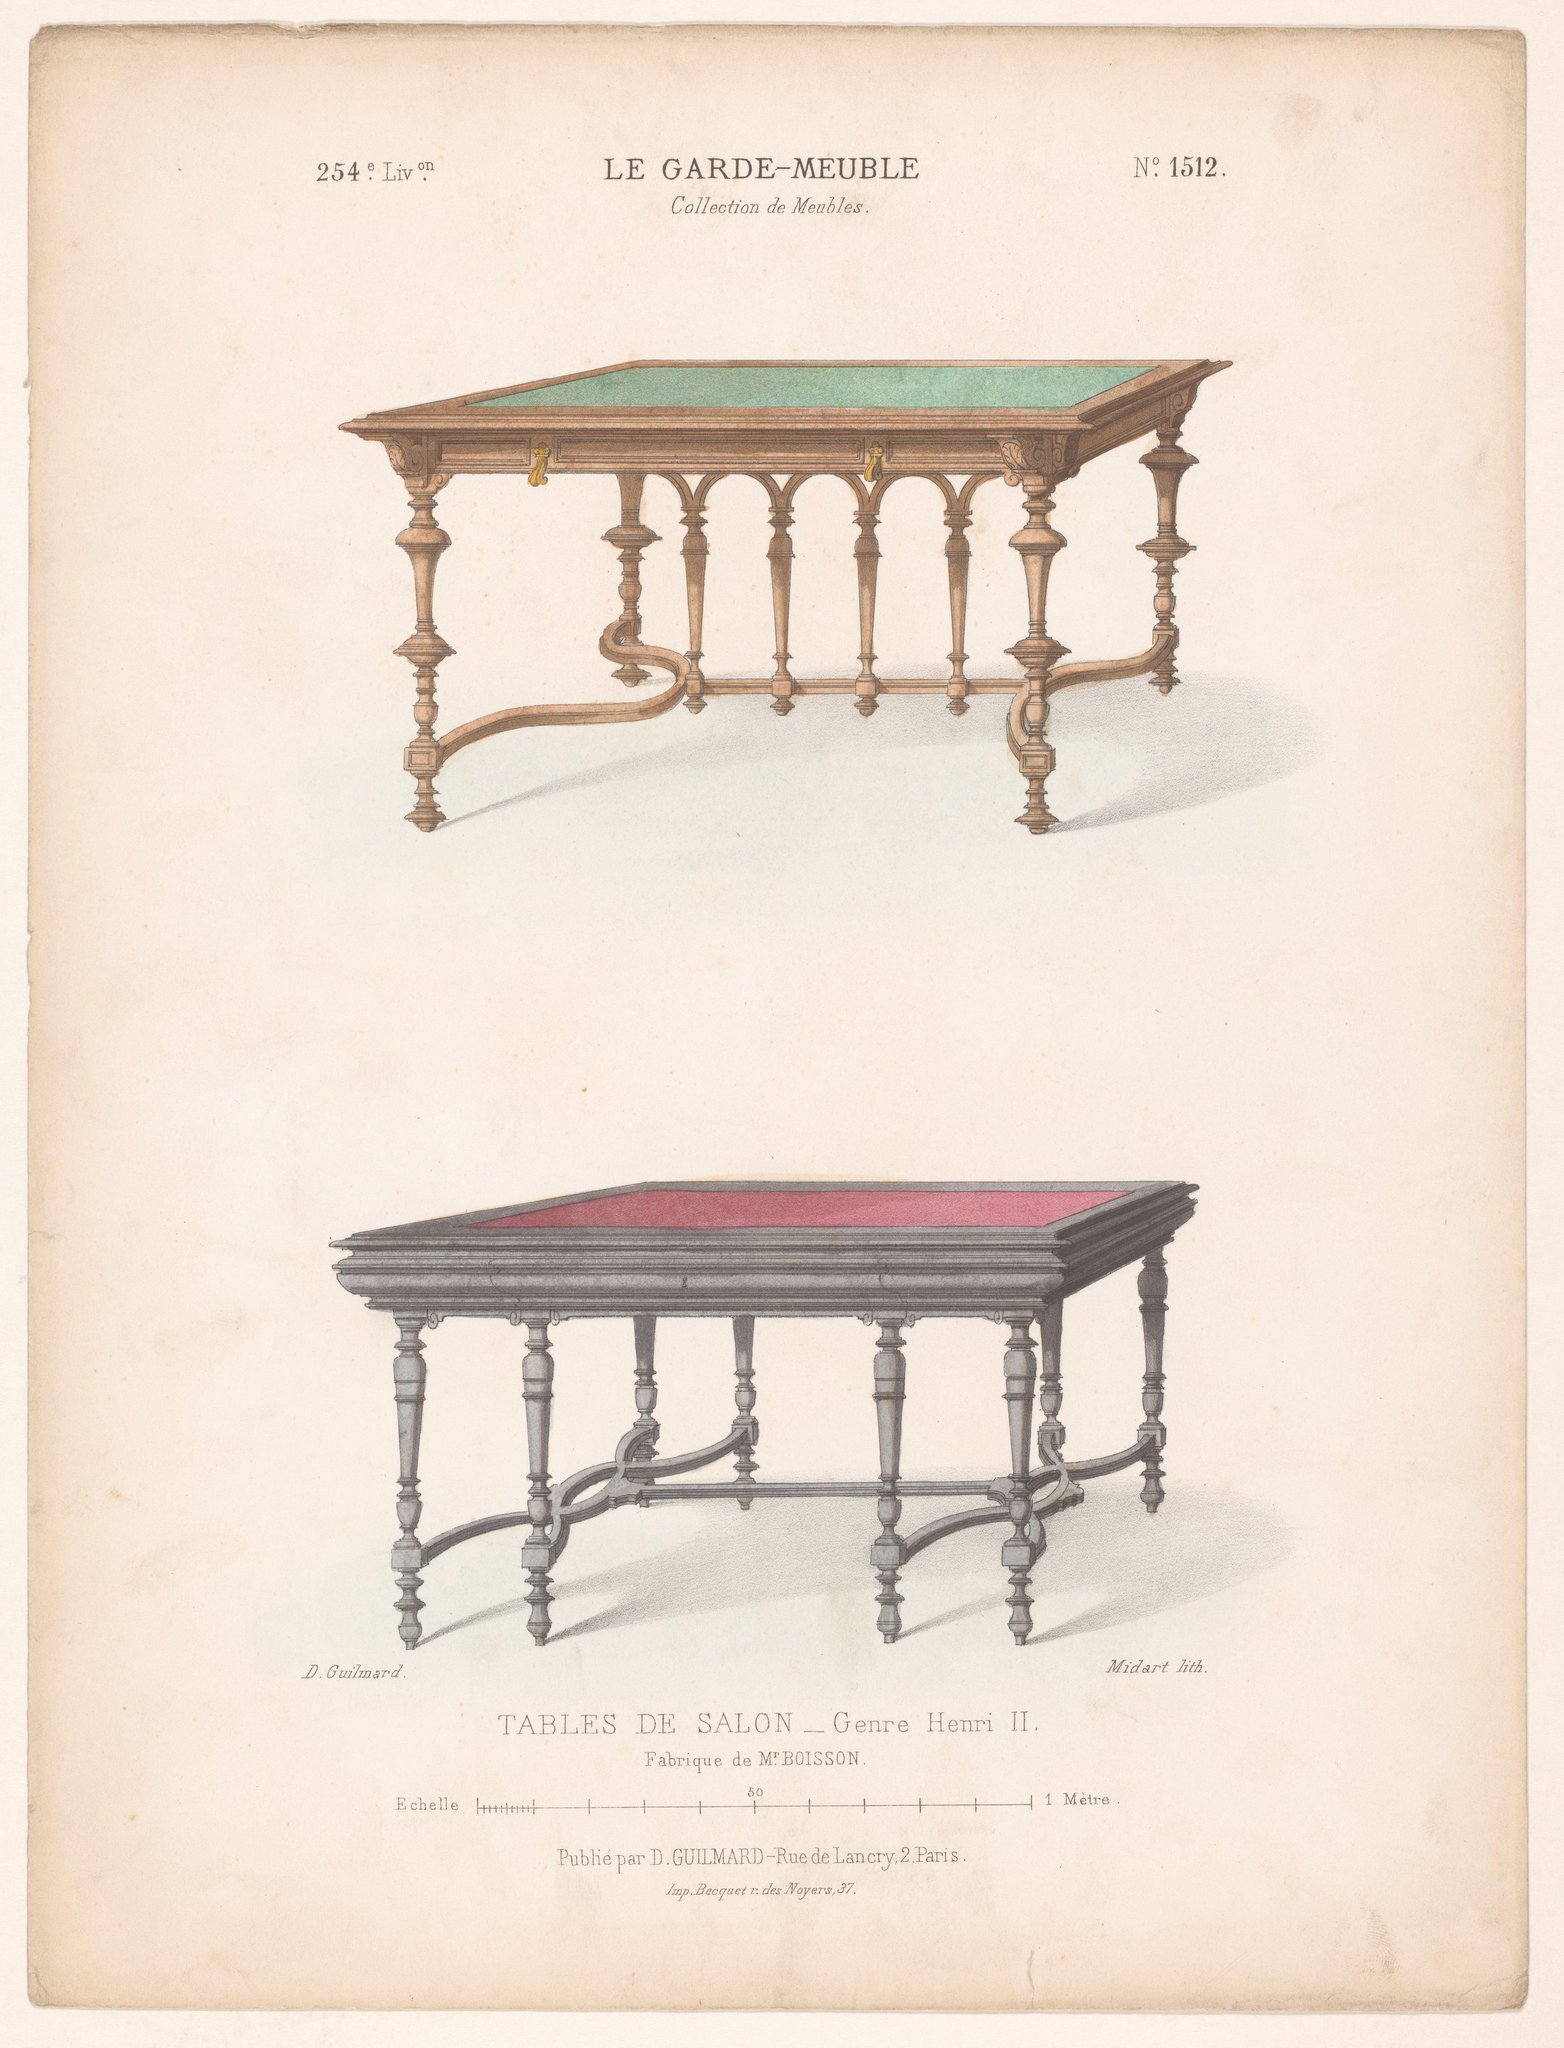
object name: print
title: Le garde-meuble / Collection de Meubles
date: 1839-1885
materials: paper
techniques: hand coloring, lithograph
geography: paris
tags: table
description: Ieder Livraison in de serie Le Garde-Meuble bevat negen platen: drie 'sièges' (zitmeubels), drie 'meubles' (diverse meubels zoals tafels en kasten) en drie 'tentures' (gordijnen en draperieën).